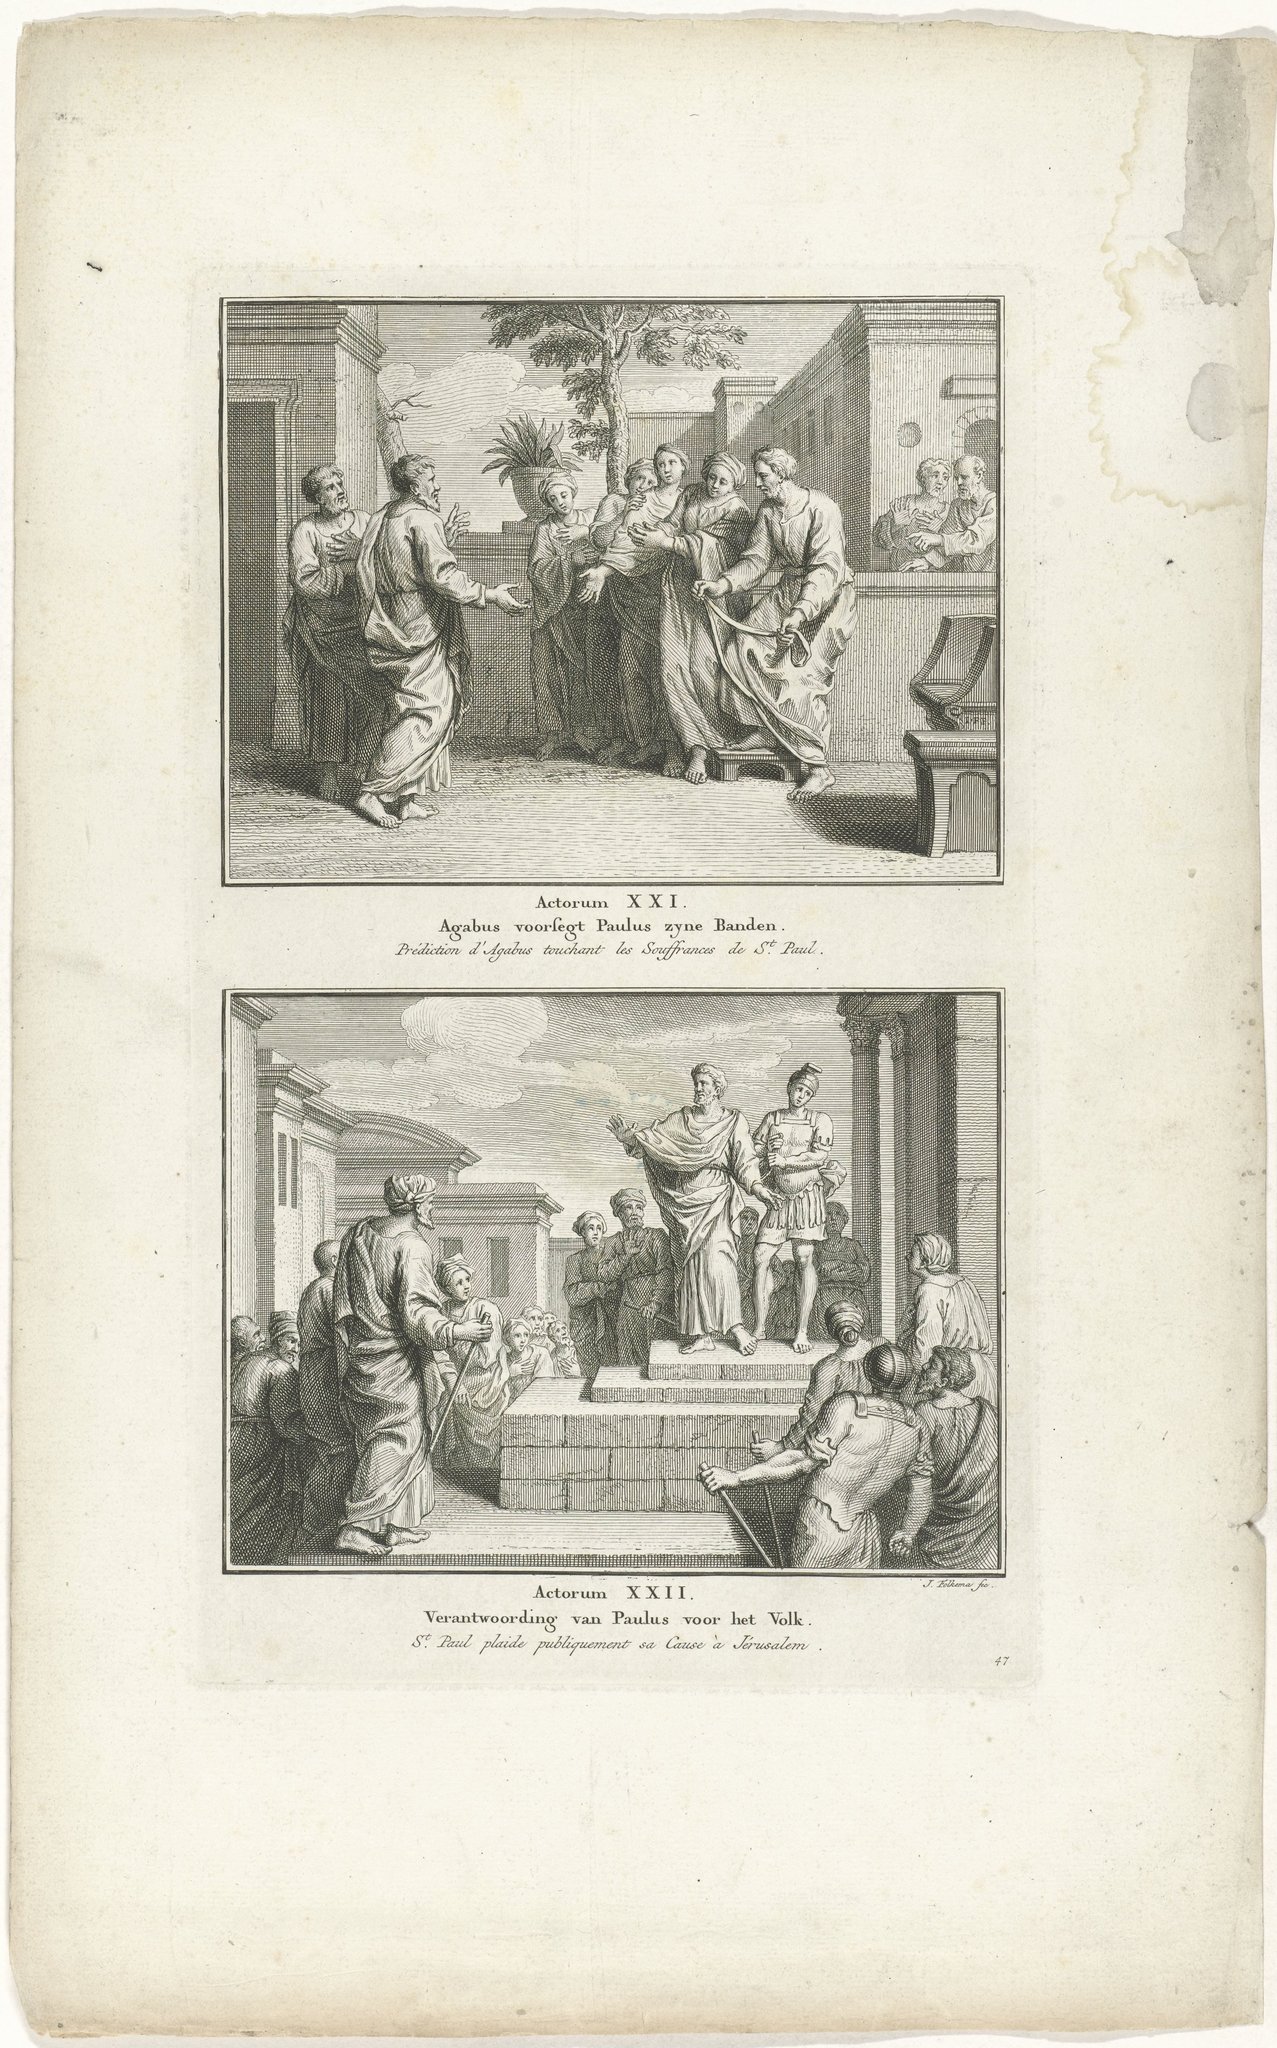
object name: book illustration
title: Profetie van Agabus en Paulus spreekt tot het volk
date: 1791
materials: paper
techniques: etching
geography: amsterdam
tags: the arrest of paul in jerusalem is foretold by agabus, who binds his own hands and feet with paul's girdle, paul speaks to the people from the stairs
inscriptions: collector's mark: Lugt 2233, collector's mark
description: Twee Bijbelse voorstellingen uit Hand. 21 en 22. Agabus voorspelt Paulus dat hij te Jeruzalem aan handen en voeten gebonden zal worden, en Paulus spreekt vanaf een trap tot het volk. Twee voorstellingen van één plaat, elk voorzien van een titel in het Nederlands en Frans. Geheel rechtsonder genummerd: 47.